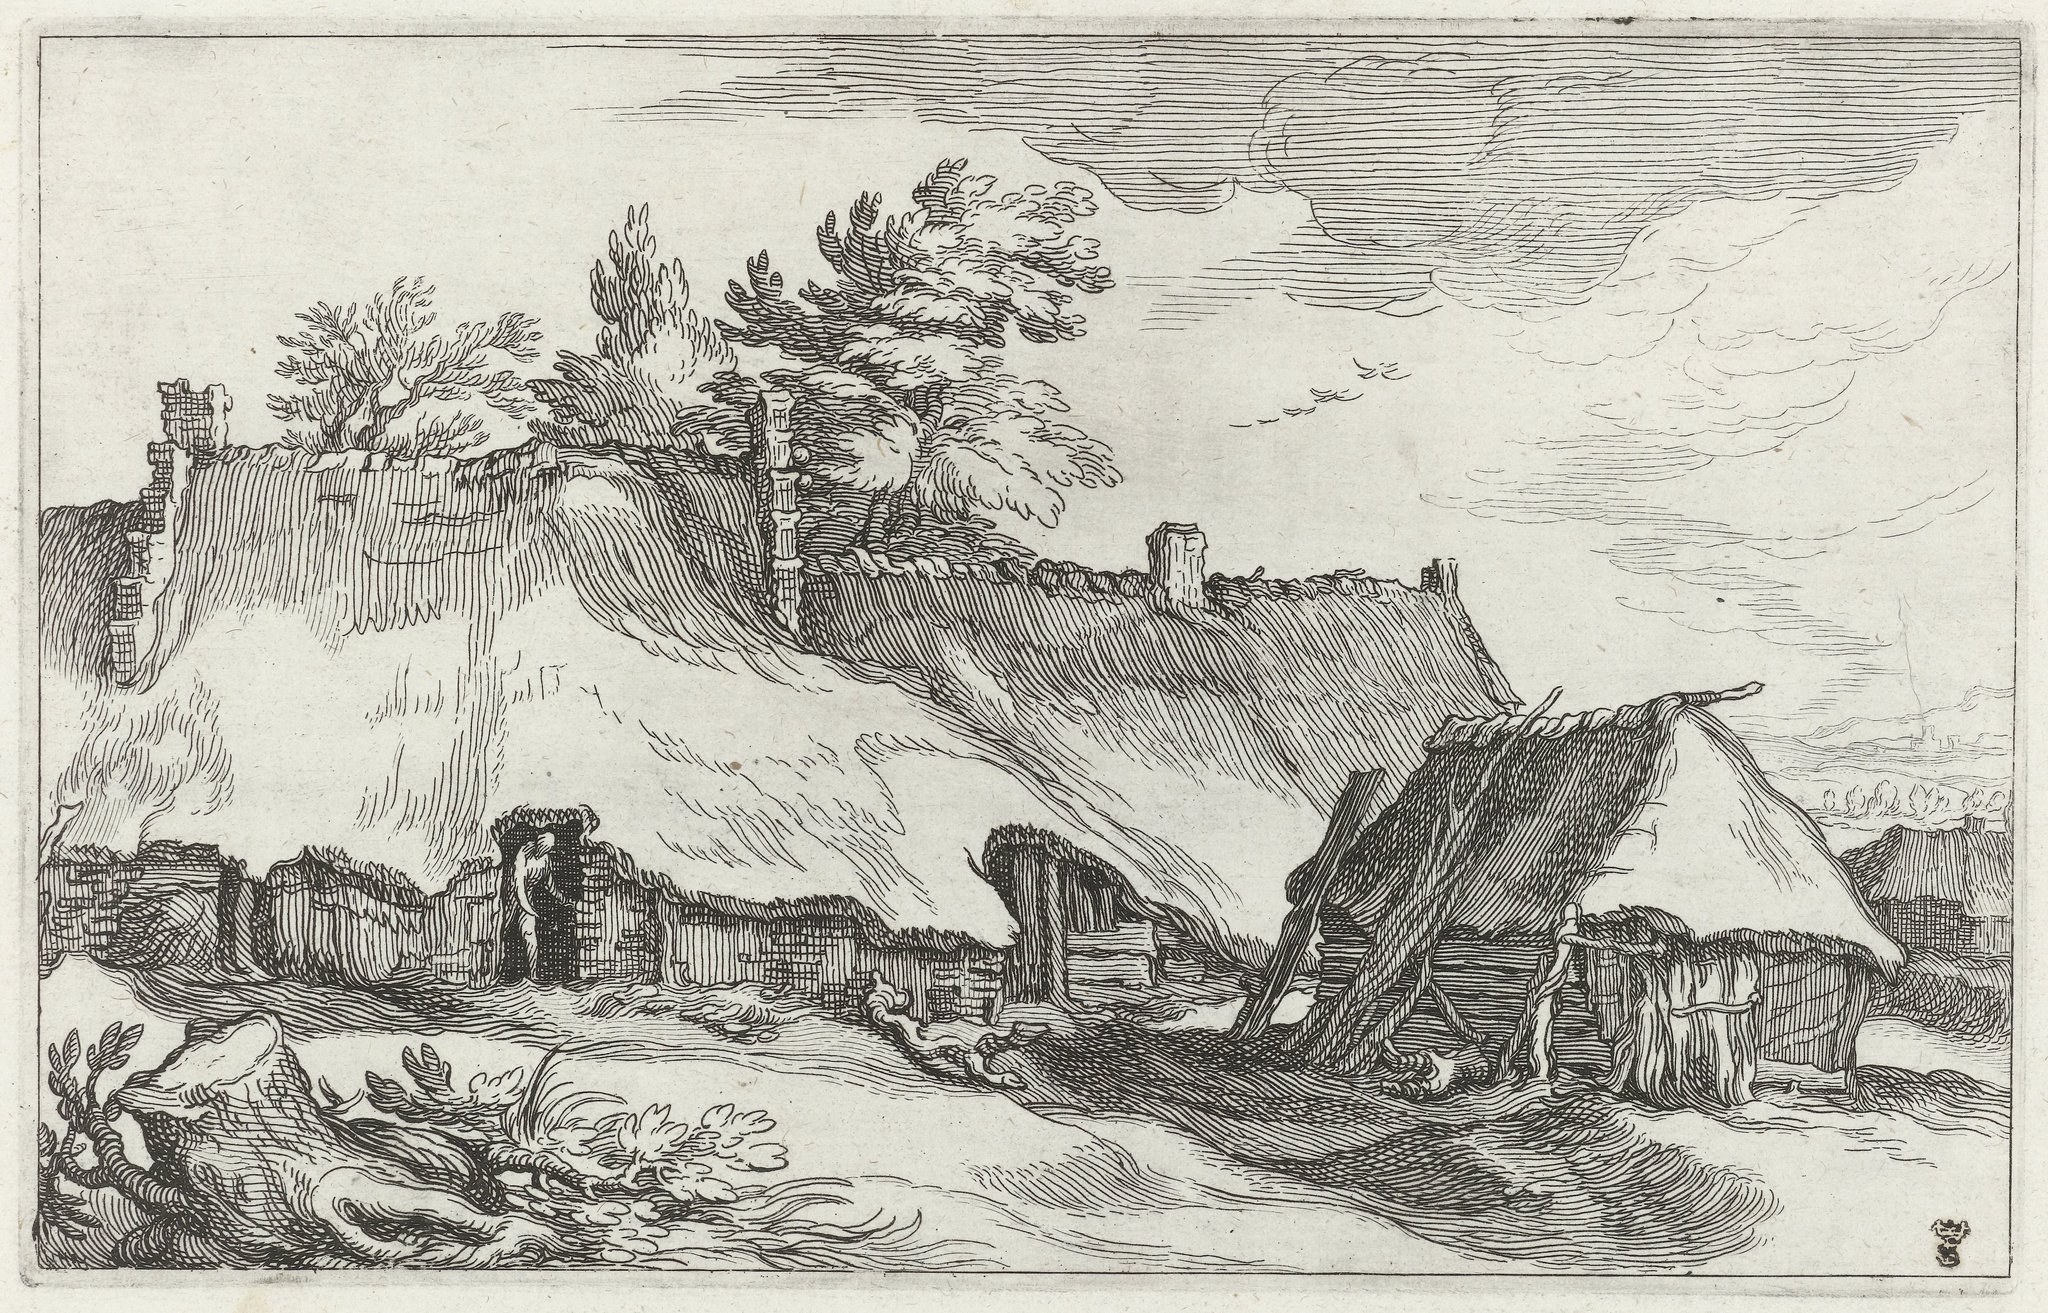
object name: print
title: Landschap met boerderij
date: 1614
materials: paper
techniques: etching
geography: amsterdam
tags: farm (building)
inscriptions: collector's mark: ‘FS’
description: Prent uit een serie van twintig van landschappen met boerderijen. Erf met boerderij. In de deuropening een figuur, rechts een schuur.